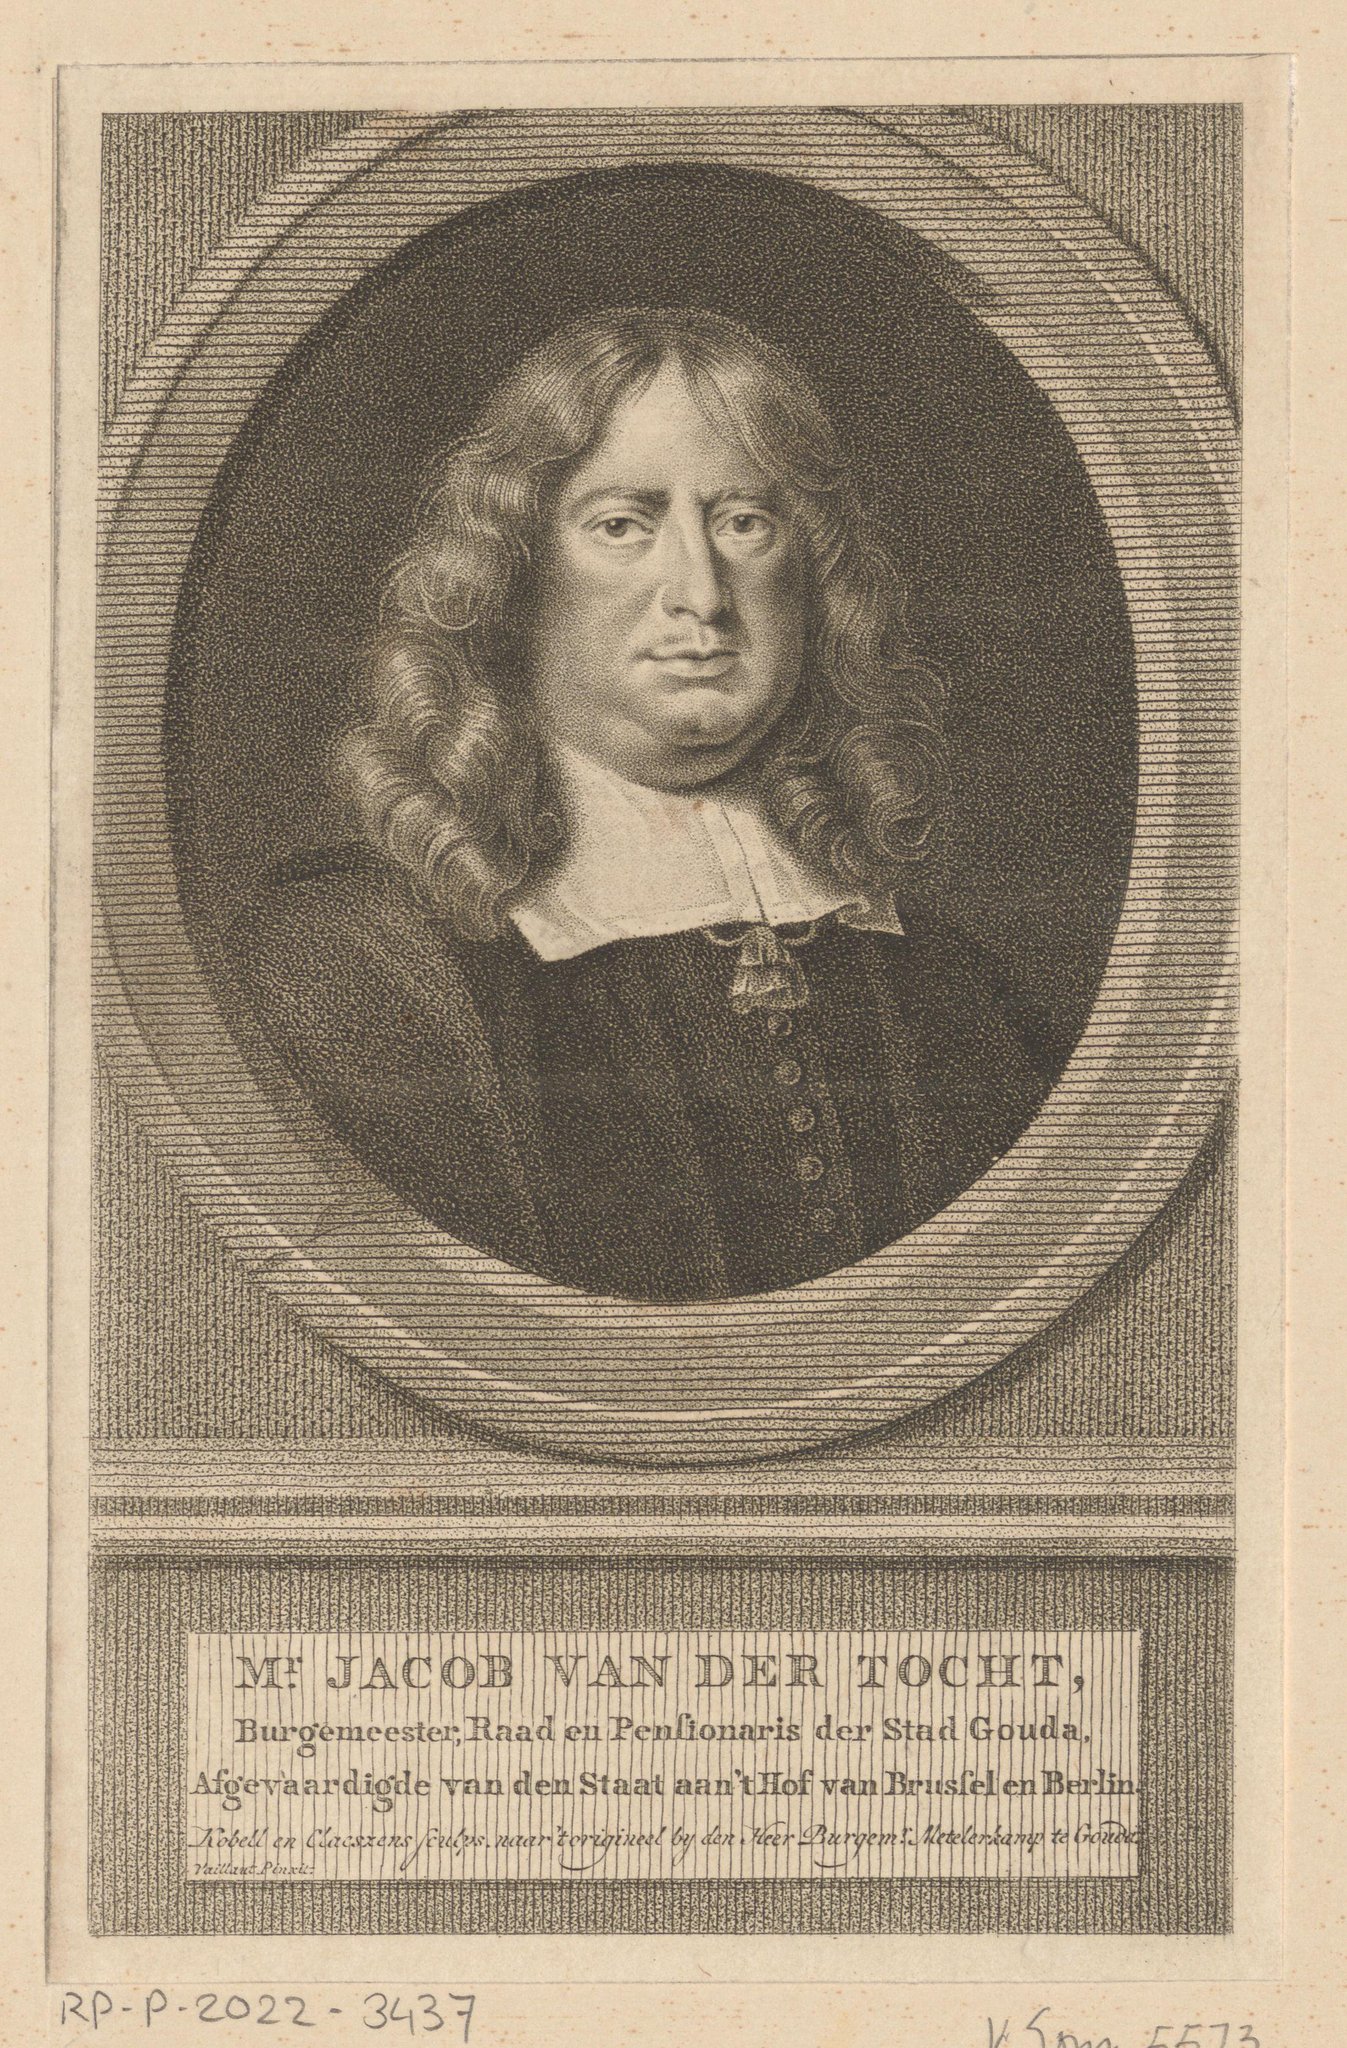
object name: print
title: Portret van Jacob van der Tocht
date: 1794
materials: paper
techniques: etching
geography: netherlands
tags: mayor, mayor, burgomaster, historical persons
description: Prent waarschijnlijk uit: Wijn, Hendrik van, e.a. Bijvoegsel en aanmerkingen voor het dertiende deel der Vaderlandsche Historie van Jan Wagenaar. Amsterdam: Johannes Allart, 1794.